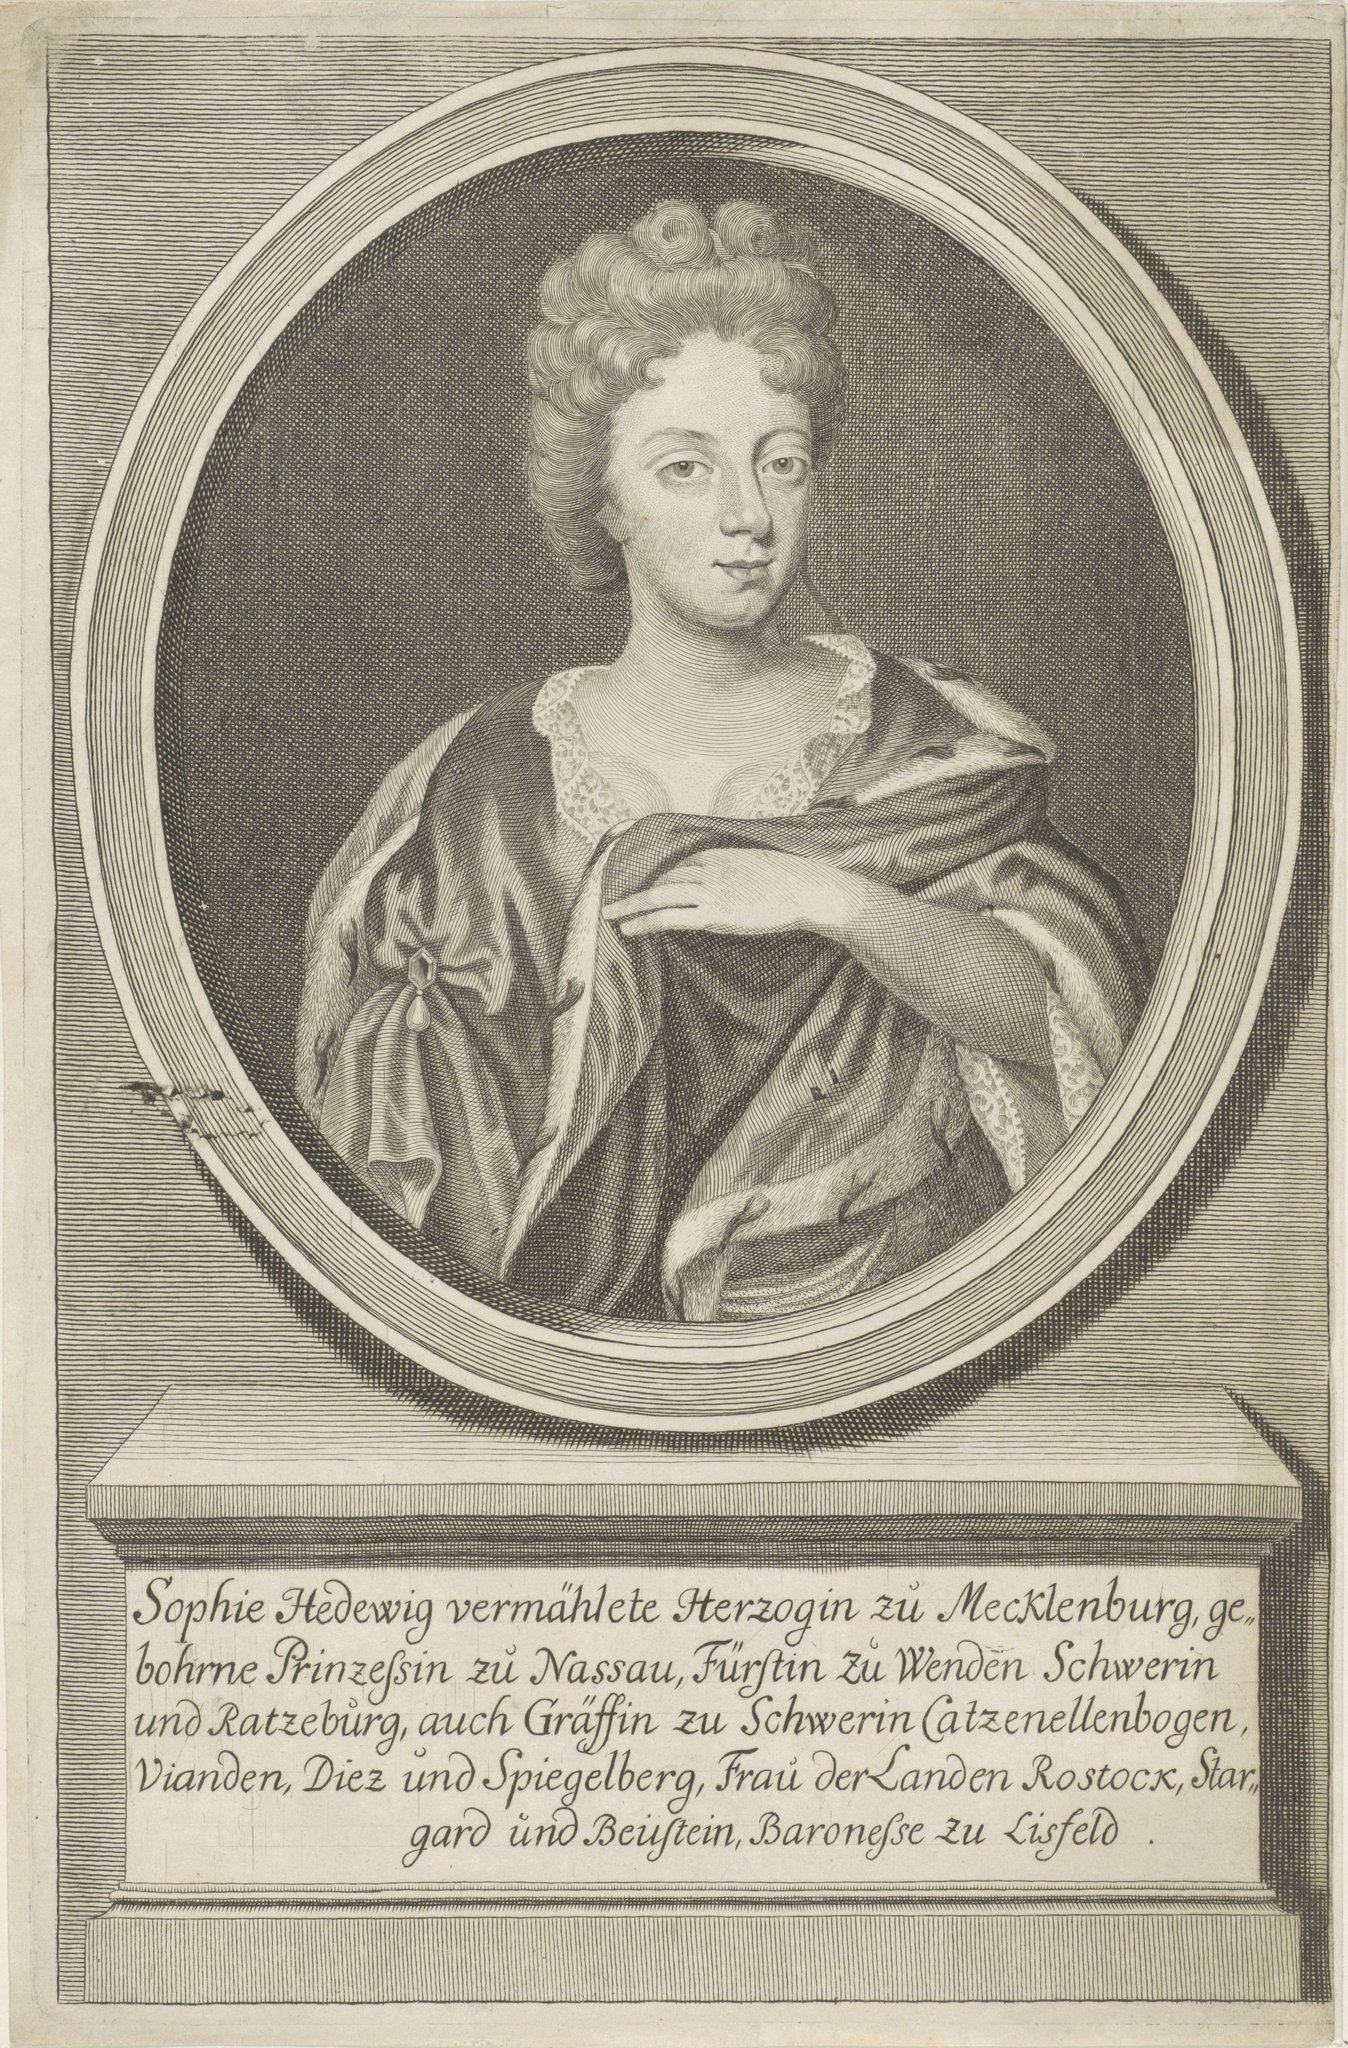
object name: print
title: Portret van Sophia Hedwig, gravin van Nassau-Dietz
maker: Anonymous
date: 1708-1799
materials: paper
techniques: engraving, etching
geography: low countries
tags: leeuwarden, oranienstein, schloss, sophia hedwig gravin van nassau-dietz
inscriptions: collector's mark: Lugt 2228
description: De hier vermelde titel verwijst naar de hoogst verkregen titel van de geportretteerde, niet per se naar de titel die de geportretteerde op deze voorstelling draagt.